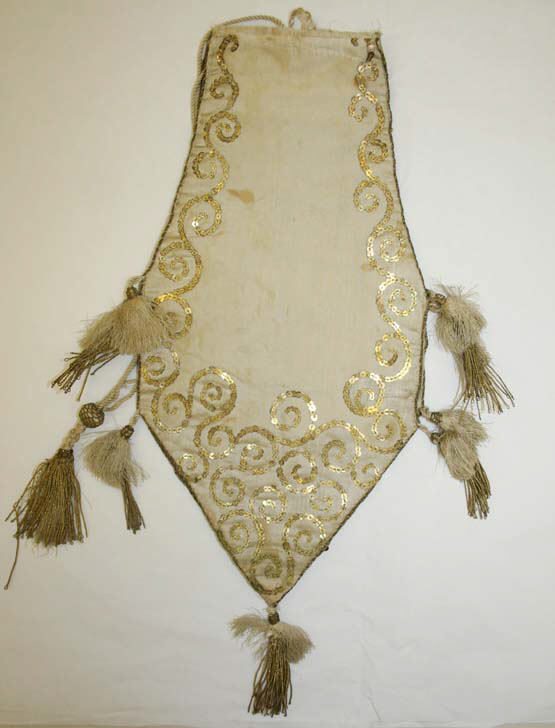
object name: reticule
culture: french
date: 1801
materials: metal, silk